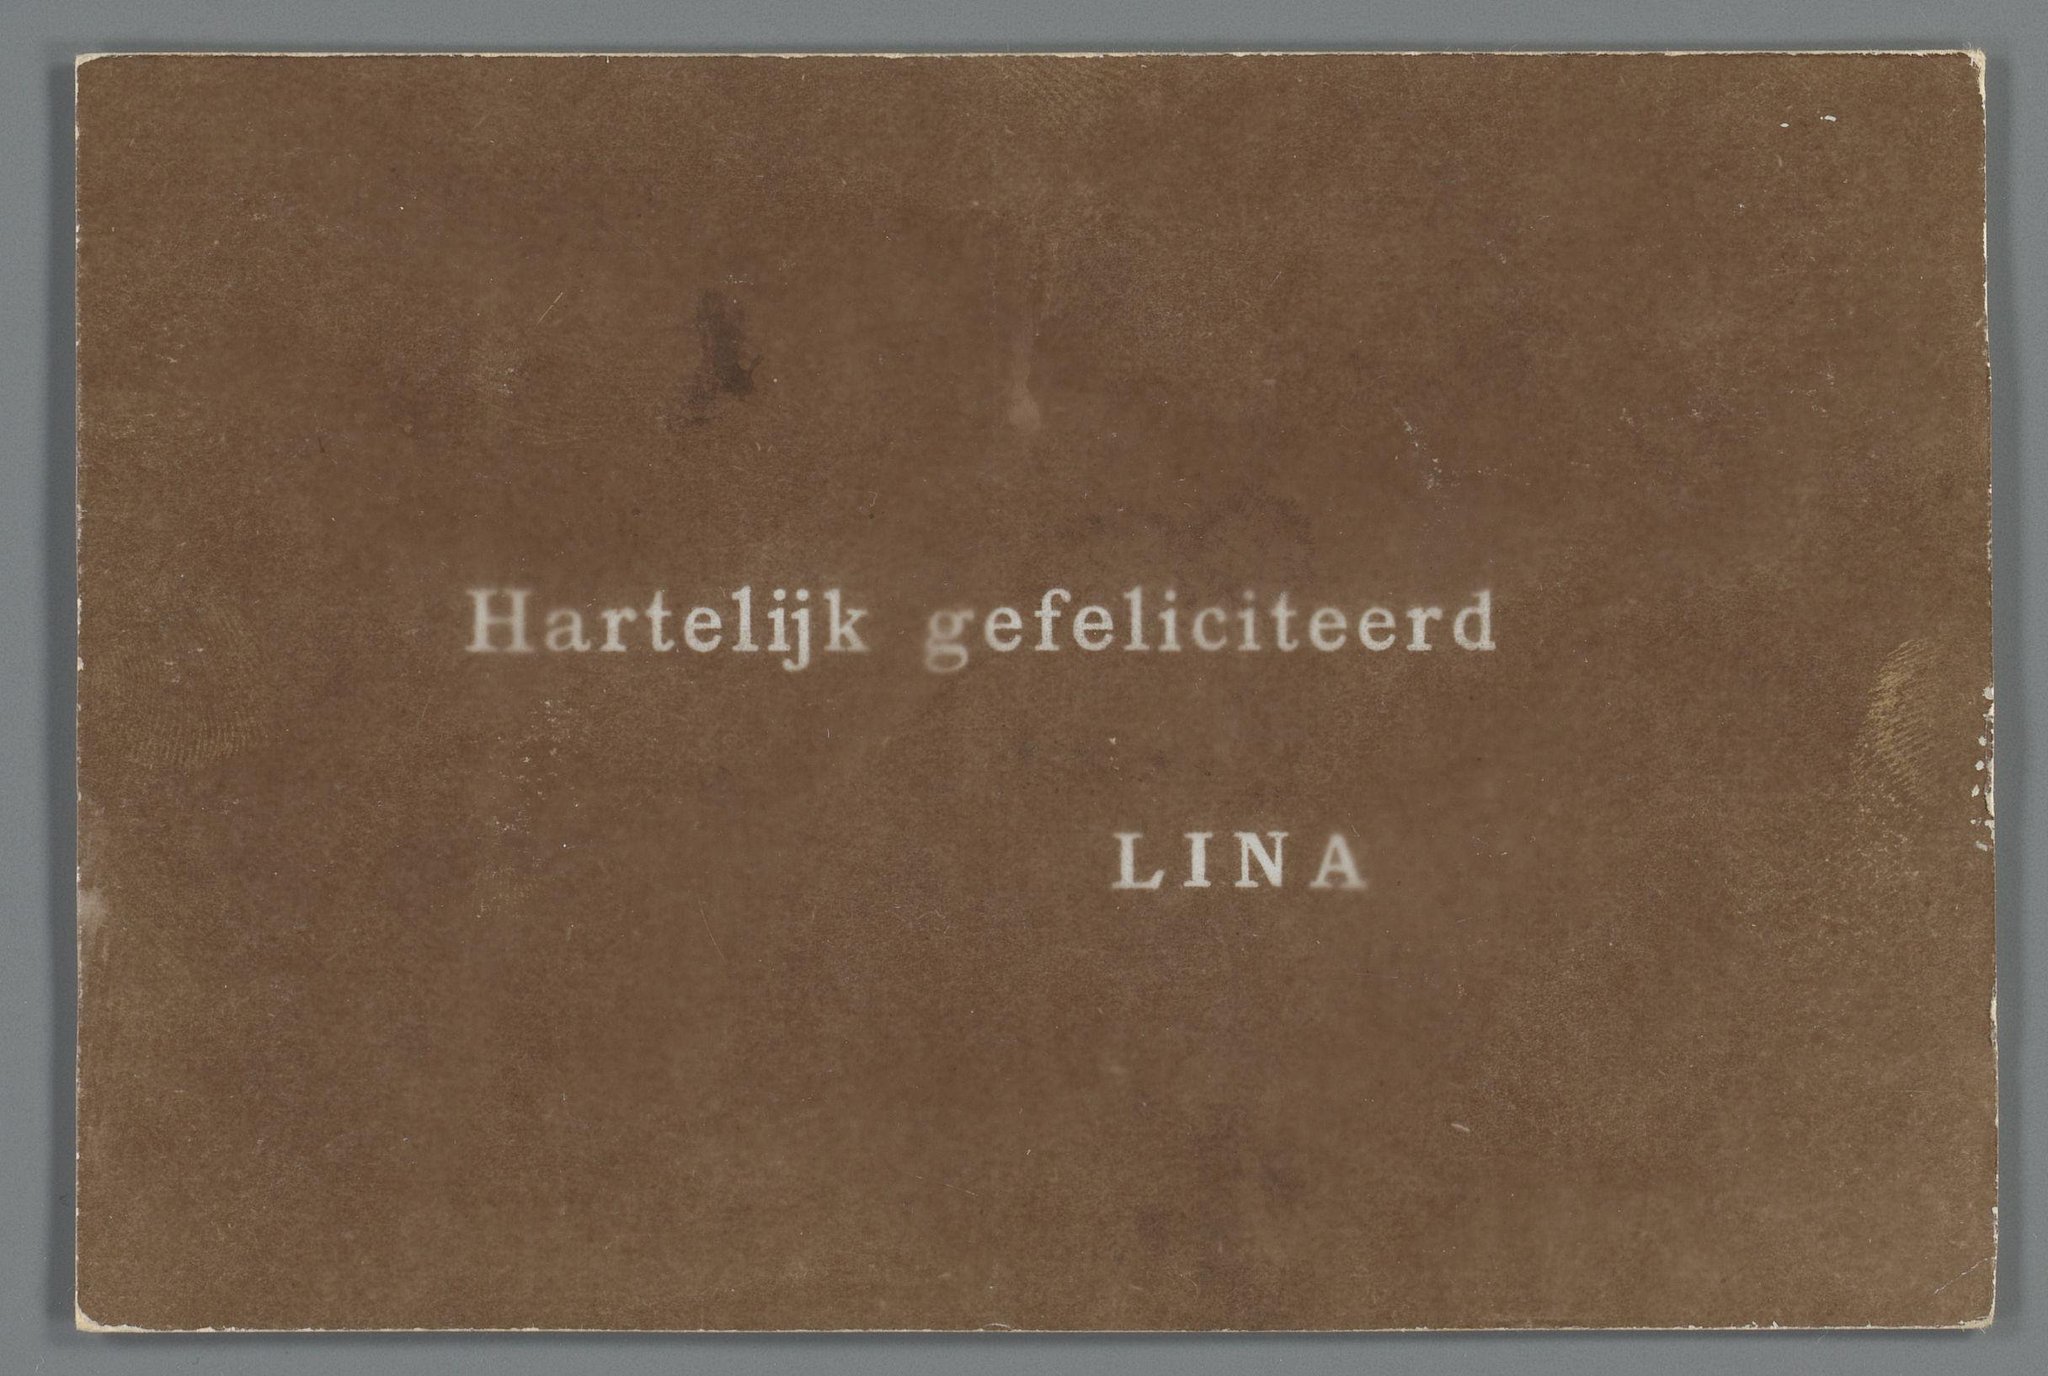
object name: greeting card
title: Wenskaart met tekst op de voorzijde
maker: Anonymous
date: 1950-1984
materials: paper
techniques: gelatin silver print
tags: birthday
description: Wenskaart met op de voorzijde: Hartelijk gefeliciteerd Lina.